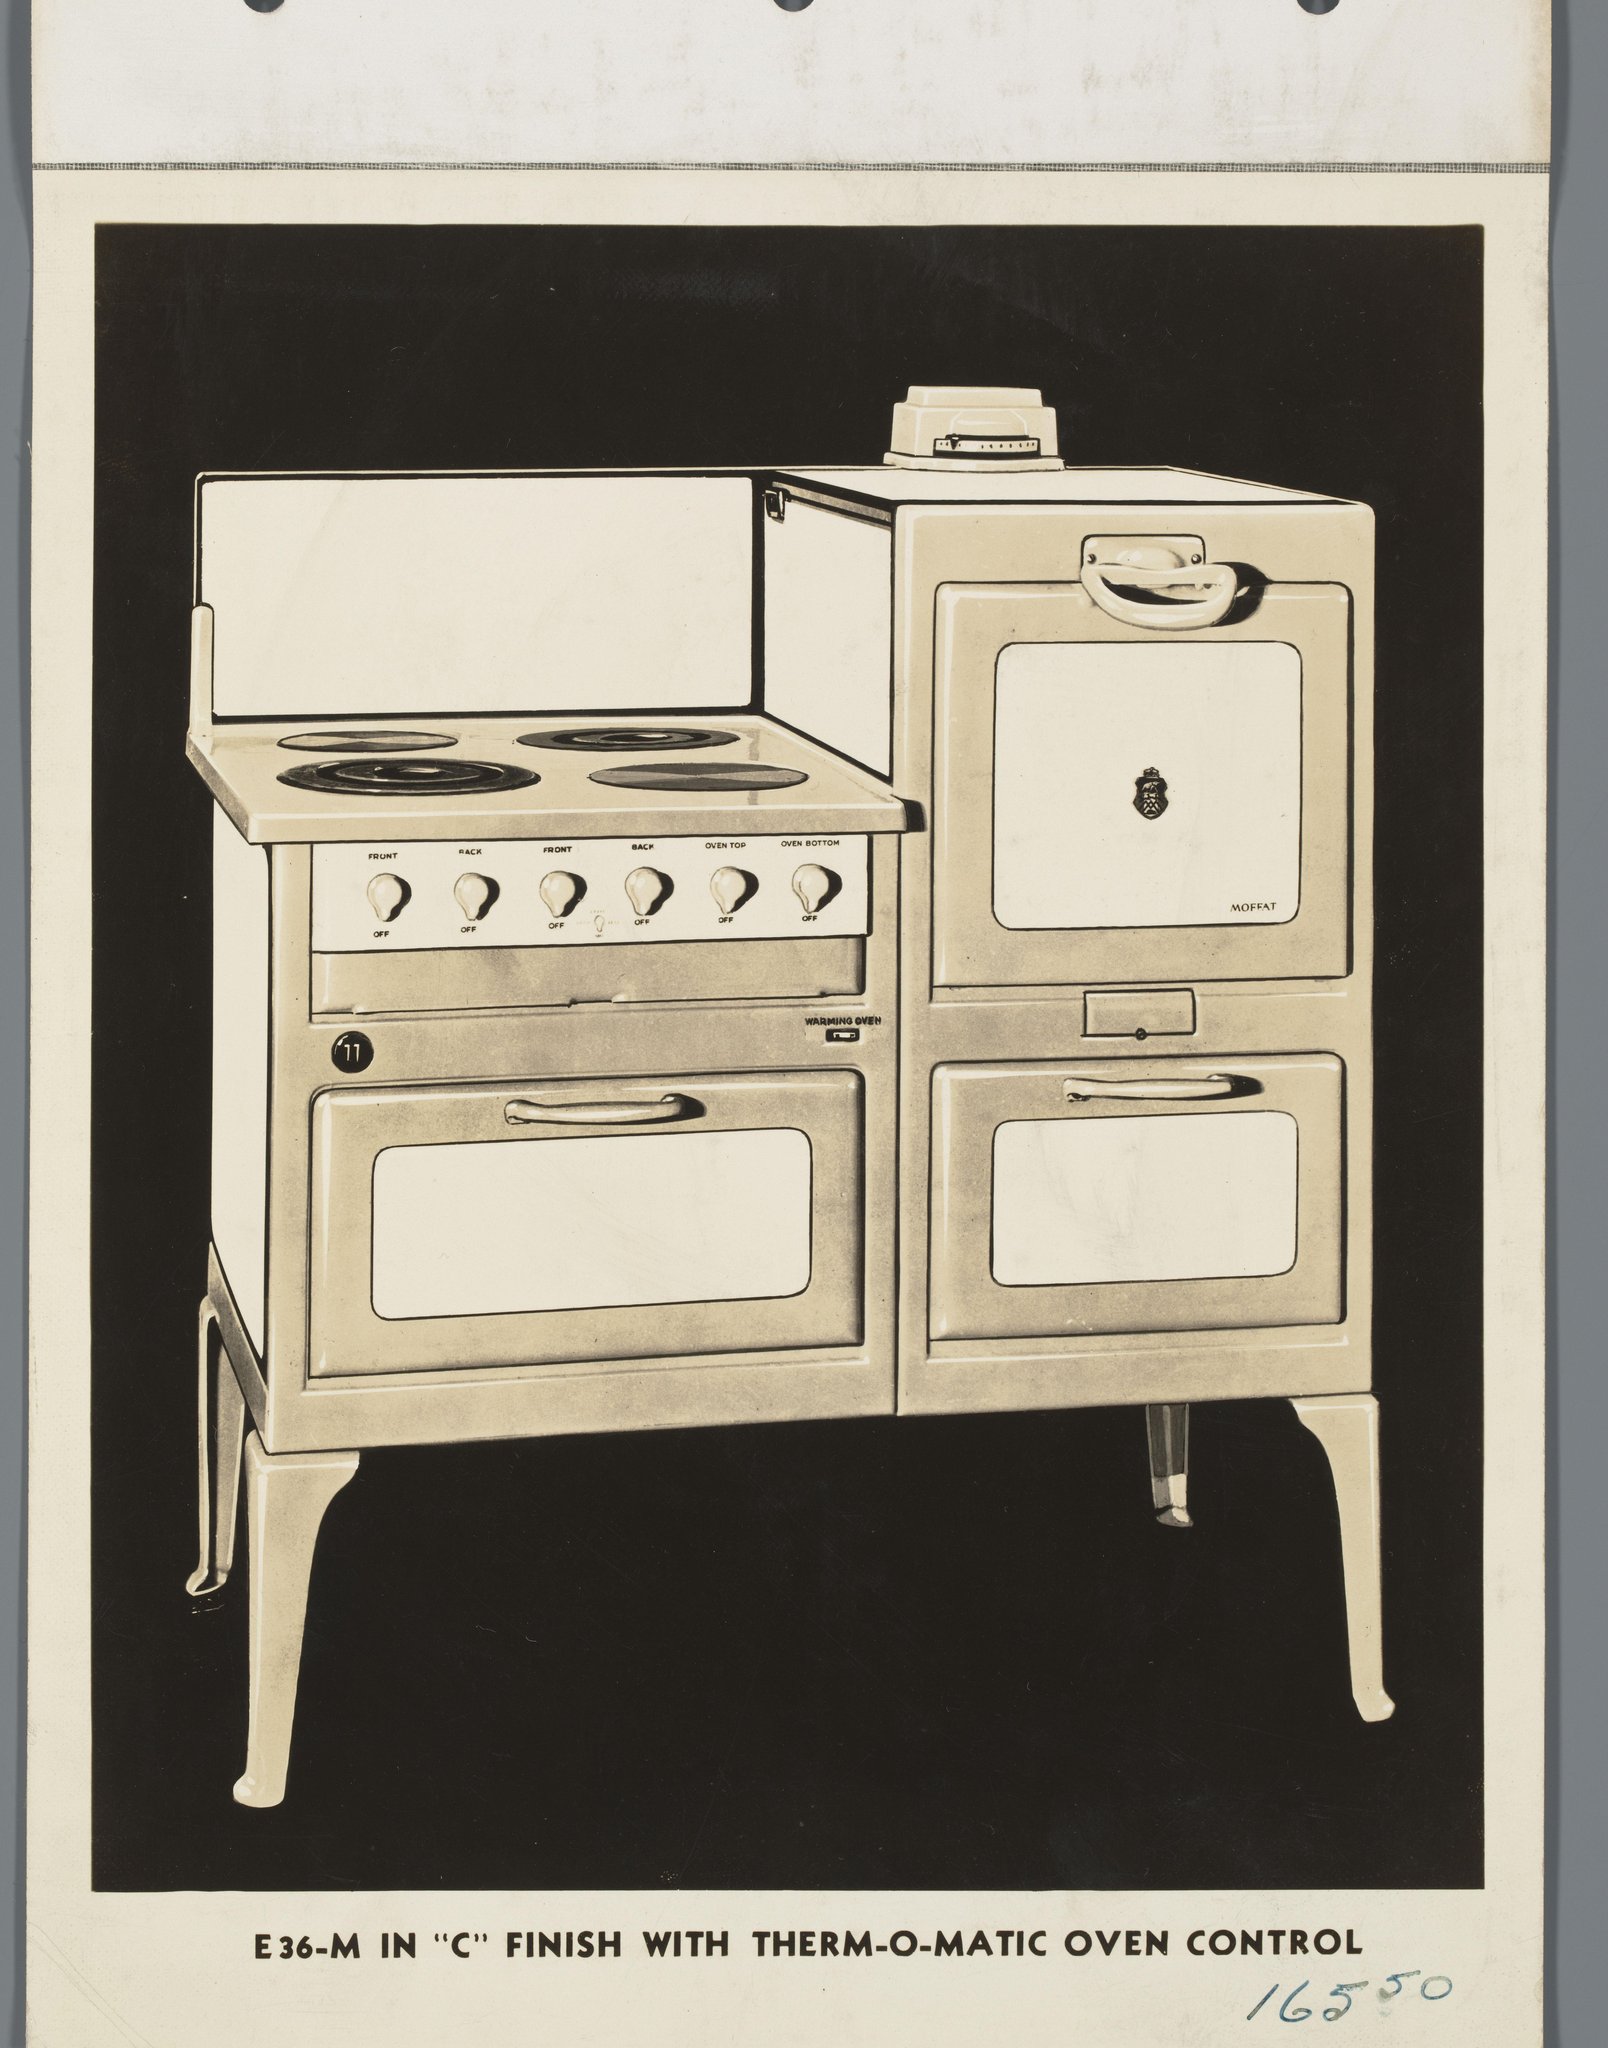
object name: photograph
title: Foto van Moffat ovens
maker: Anonymous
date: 1935-1940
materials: paper, photographic support, textile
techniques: gelatin silver print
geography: canada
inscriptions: inscription: ‘16550’, inscription: ‘E 36-M IN "C" FINISH WITH THERM-O-MATIC OVEN CONTROL’